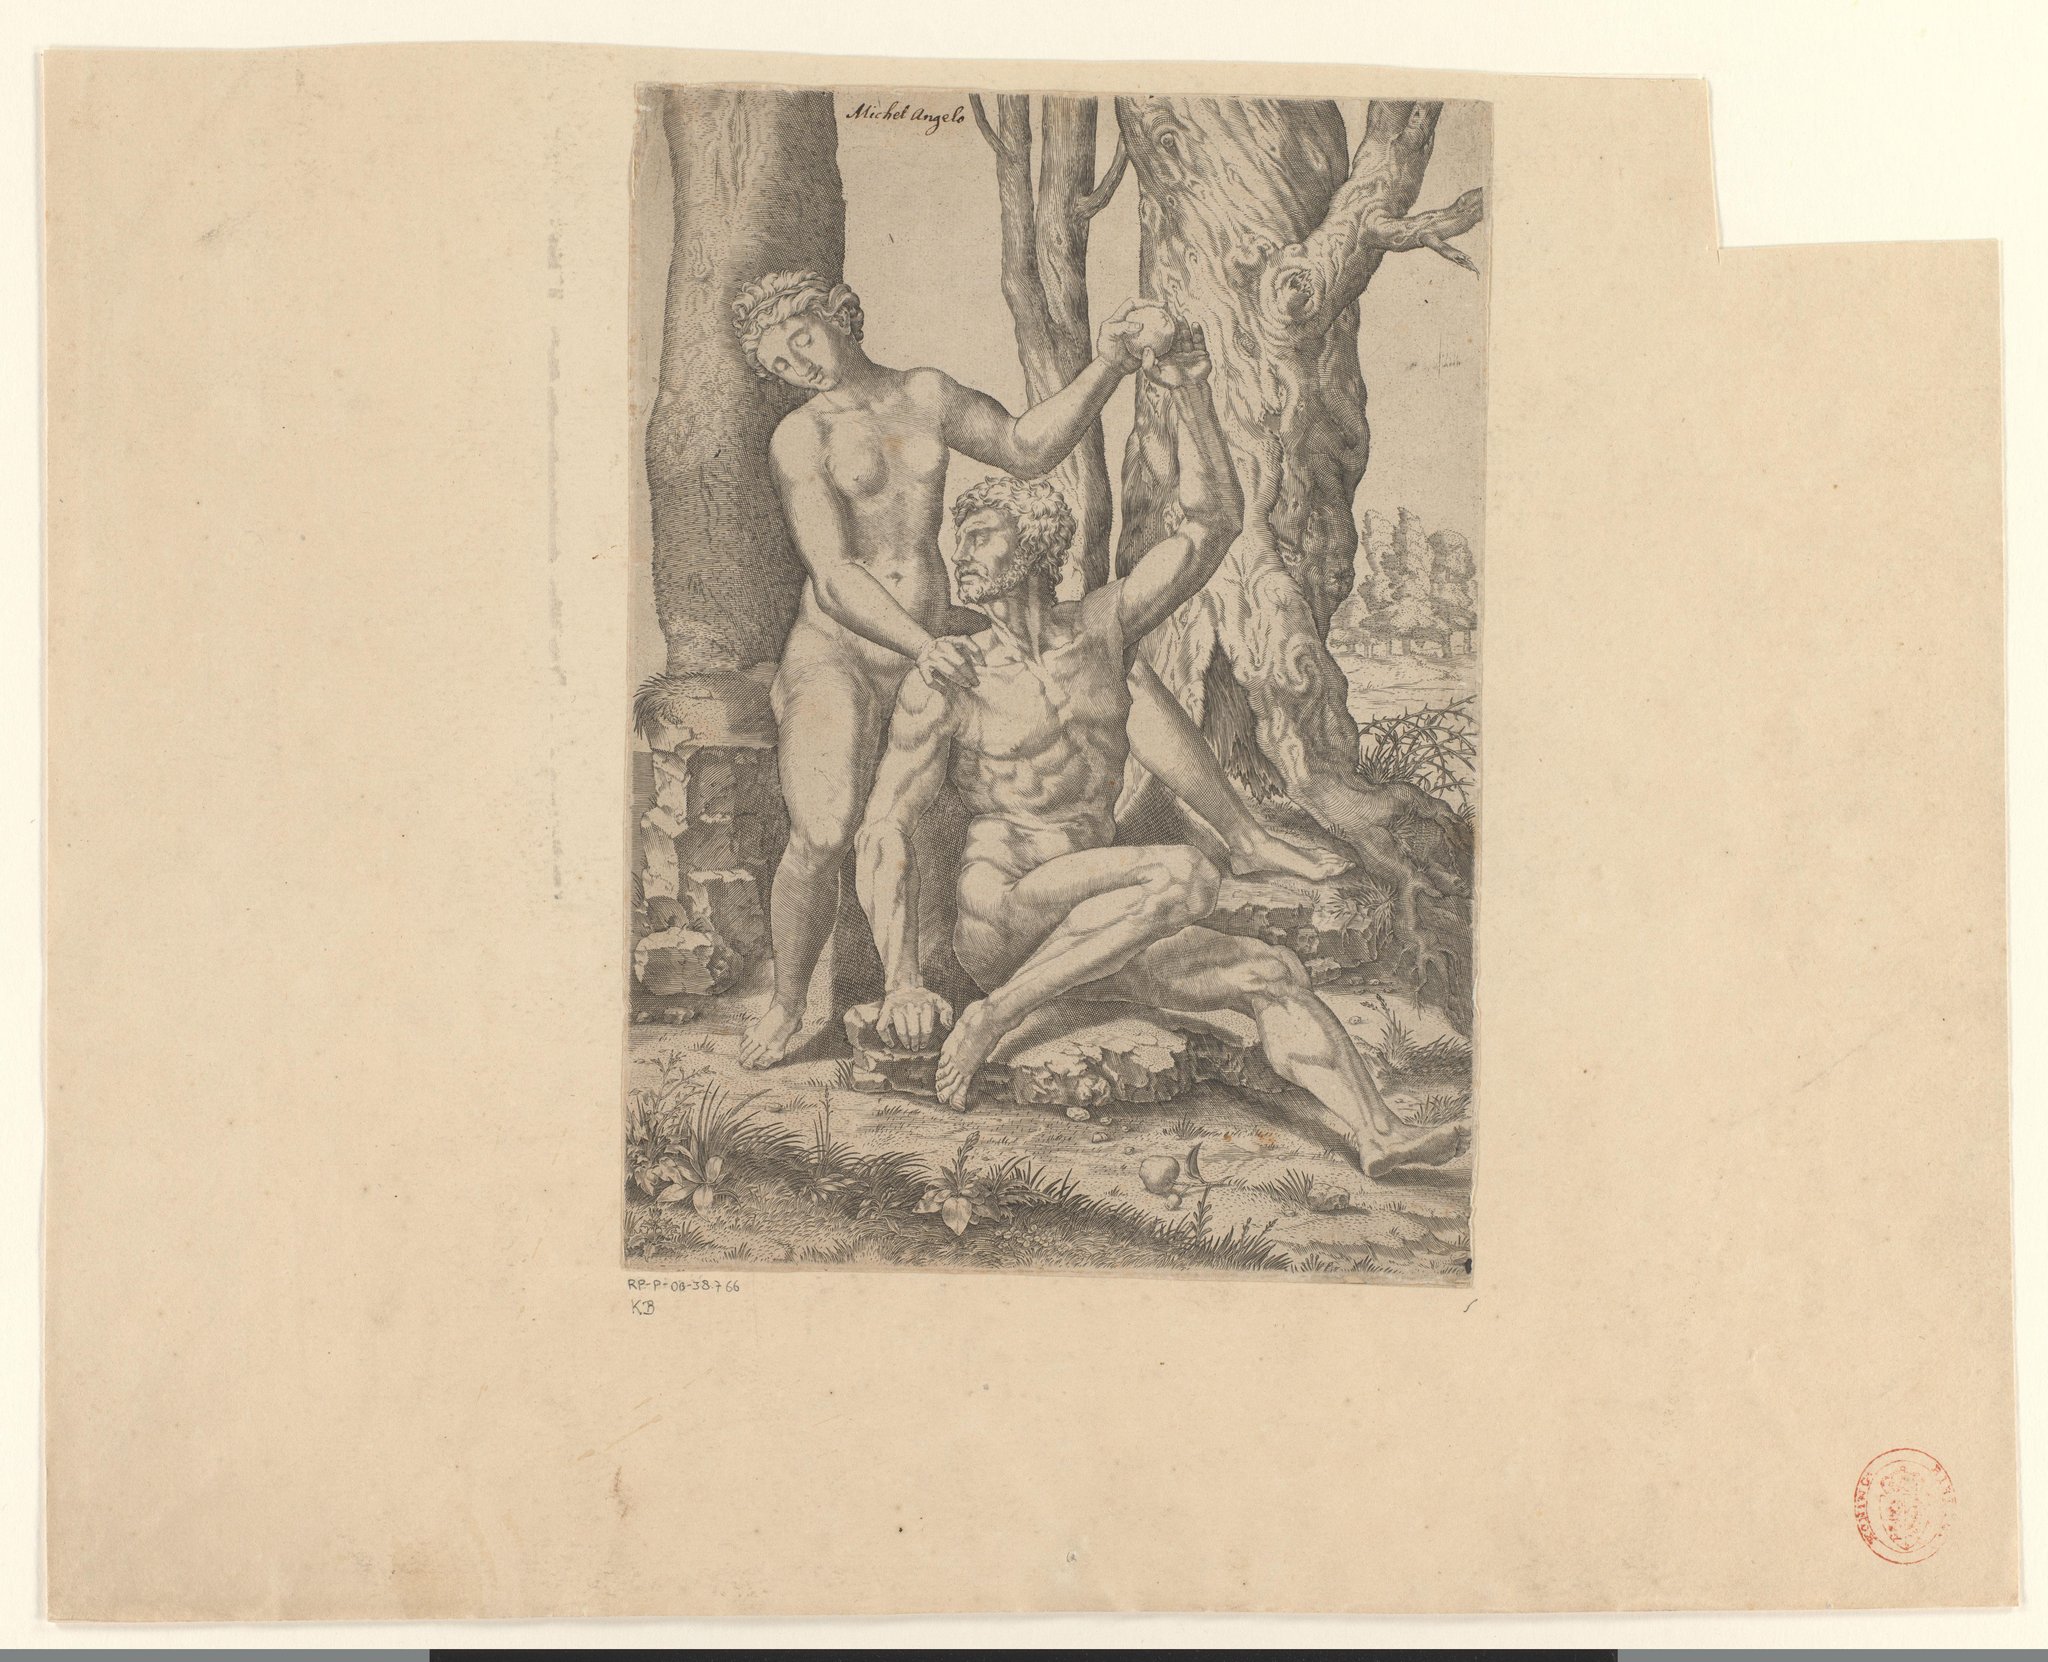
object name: print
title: Zondeval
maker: lambertus suavius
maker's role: print maker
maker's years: 1514-1564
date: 1520-1567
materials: paper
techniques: engraving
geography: italy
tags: adam and eve holding (and possibly eating) the fruit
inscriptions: collector's mark: Lugt 240, inscription: ‘Michel Angelo’, number: ‘1207’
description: De naakte Adam en Eva in het Paradijs. Samen houden zij de appel vast.